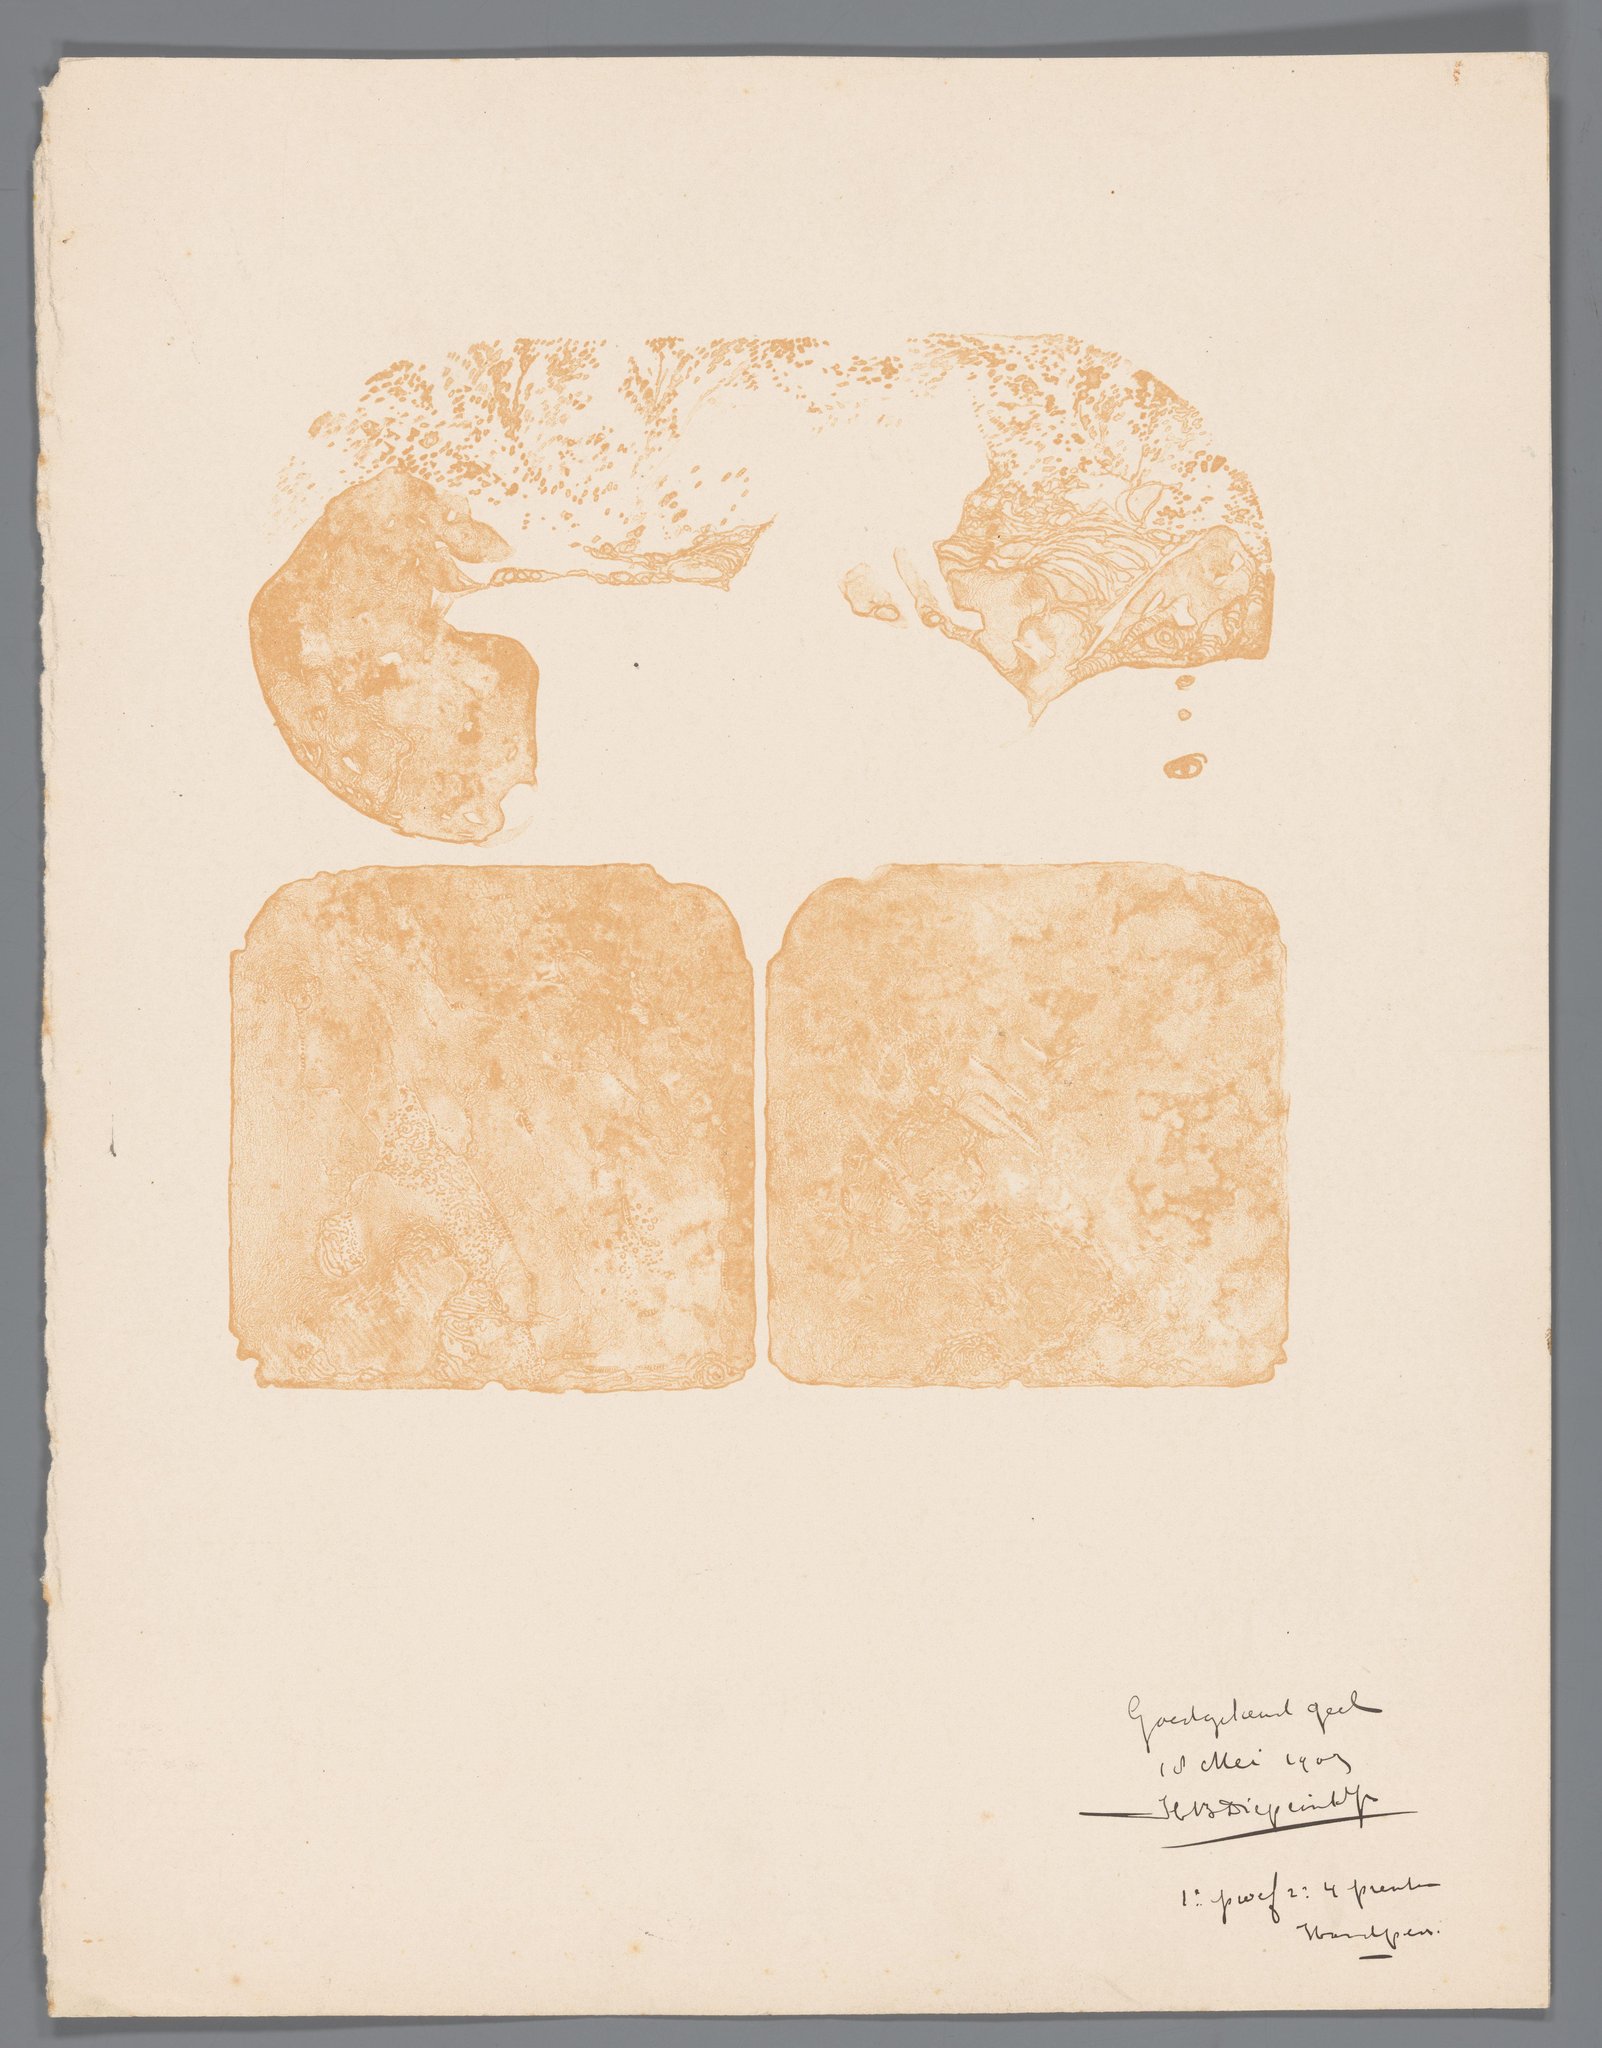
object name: print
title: Beer (Bruun) en vos (Reinaert)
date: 1909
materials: paper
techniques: lithograph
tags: fable of reynard the fox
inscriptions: collector's mark: Lugt 2228, inscription: ‘Goedgekeurd geel/ 18 Mei 1909/ HB Dieperink Jr/ 1e proef 2: 4 prenten/ Handpers’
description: Ontwerp voor: Streuvels, Stijn (Frank Lateur). Reinaert de Vos naar verschillende uitgaven van het middeleeuwsche epos. Amsterdam: L.J. Veen, 1910.